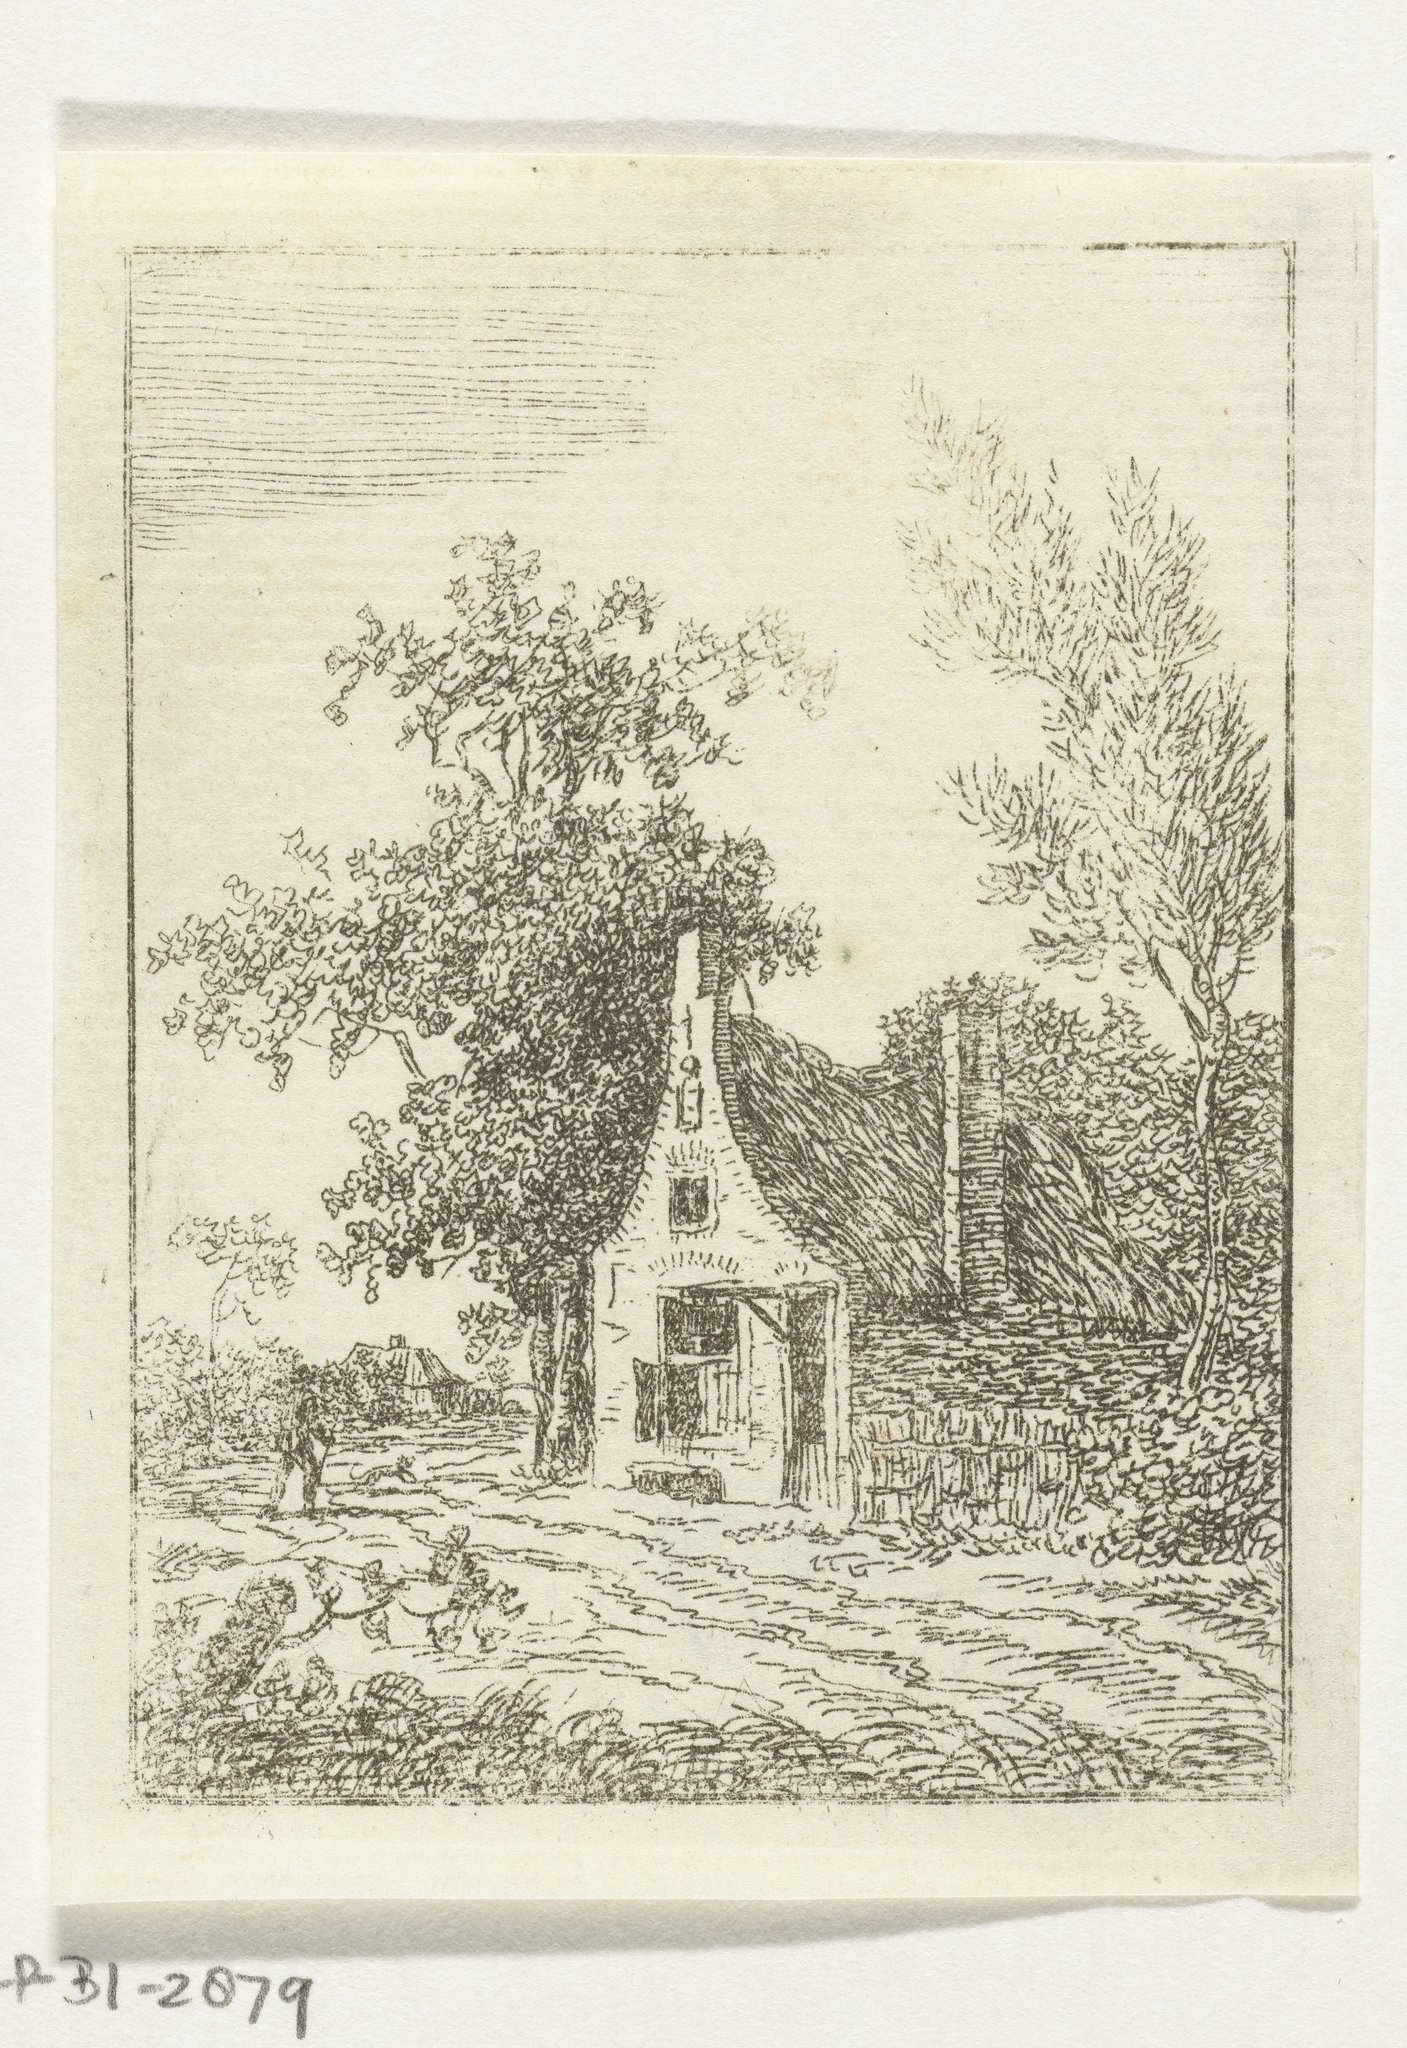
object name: print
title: Huis met halsgevel tussen bomen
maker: anthonie van den bos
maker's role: draughtsman, print maker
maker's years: 1763-1838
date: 1778-1838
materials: paper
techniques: printmaking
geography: netherlands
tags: landscapes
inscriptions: collector's mark: Lugt 2228